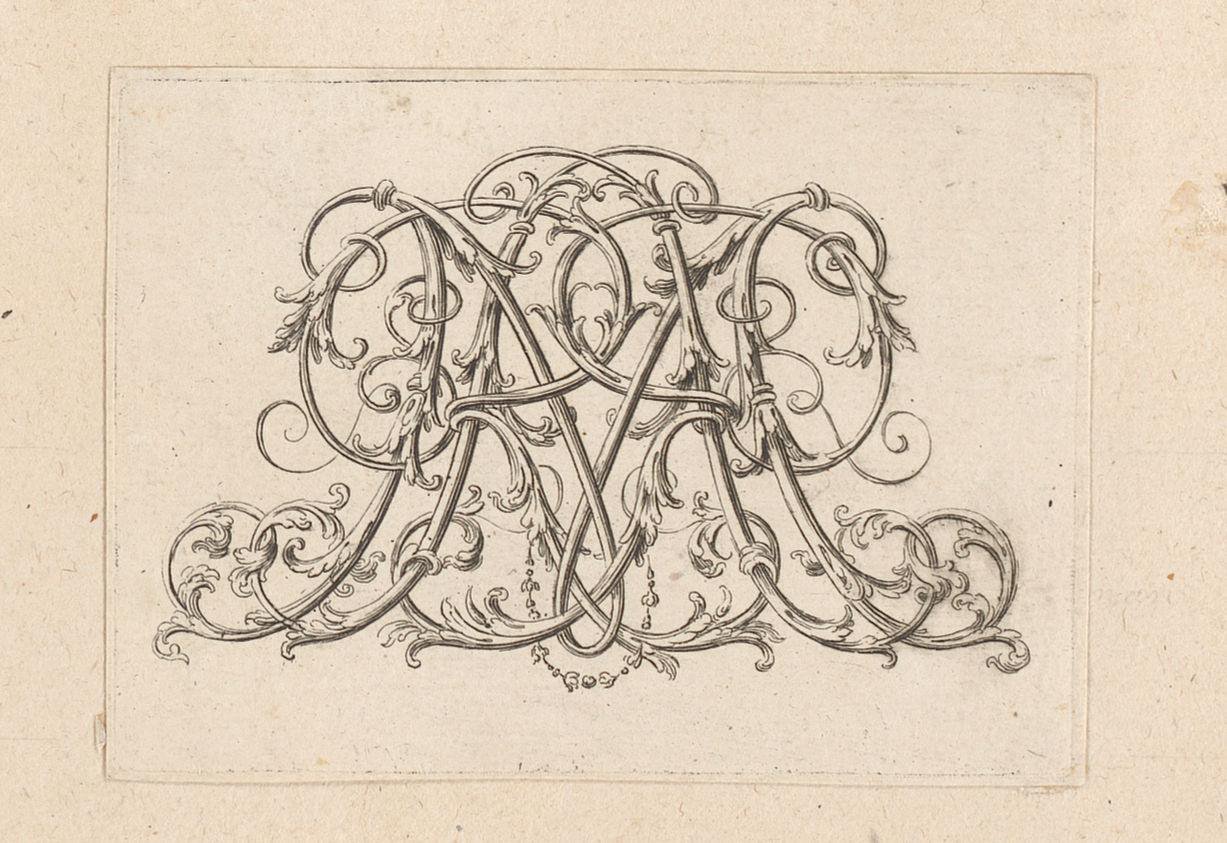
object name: book illustration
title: Vignet met de initialen 'RMR' vervlochten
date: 1708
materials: paper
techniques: etching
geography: paris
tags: initial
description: Prent gebruikt voor: Montmort, Pierre Rémond de. Essay d'analyse sur les jeux de hazard. Parijs: Jacques Quillau, 1708.